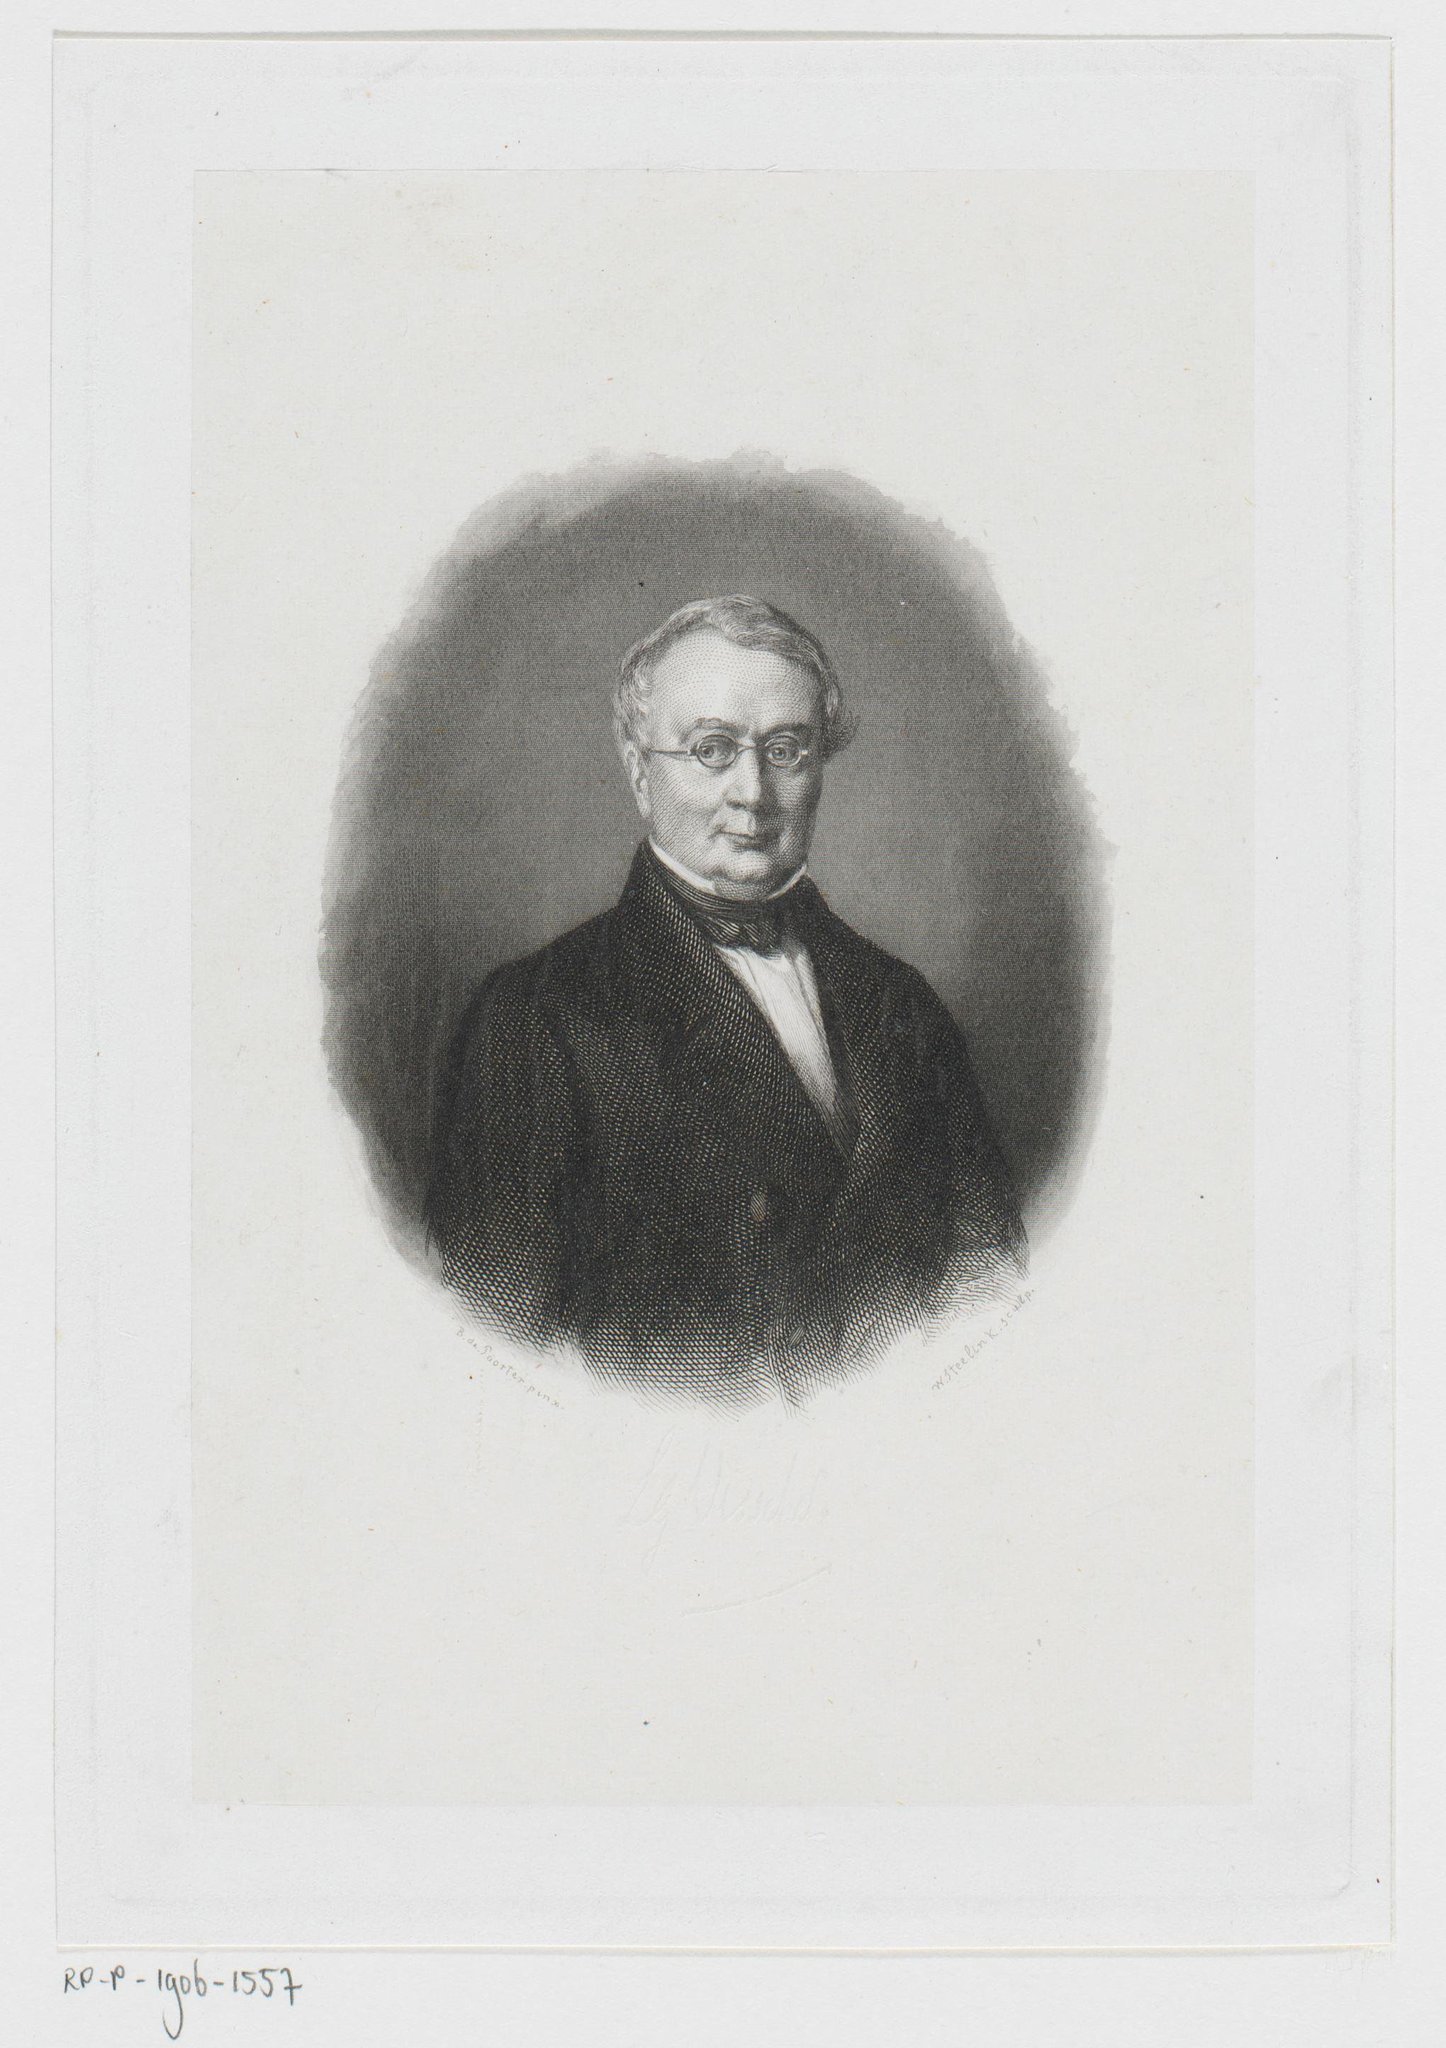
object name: print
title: Portret van Lodewijk Gerard Visscher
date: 1857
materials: paper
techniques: etching, engraving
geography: amsterdam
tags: utrecht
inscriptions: collector's mark: Lugt 2228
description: Portret van Lodewijk Gerard Visscher, professor te Utrecht.